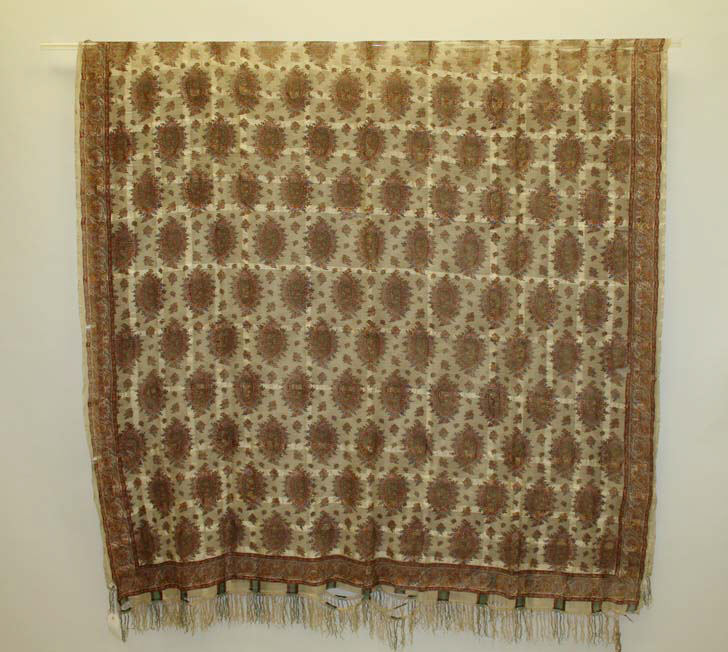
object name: shawl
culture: french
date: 1854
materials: silk, wool